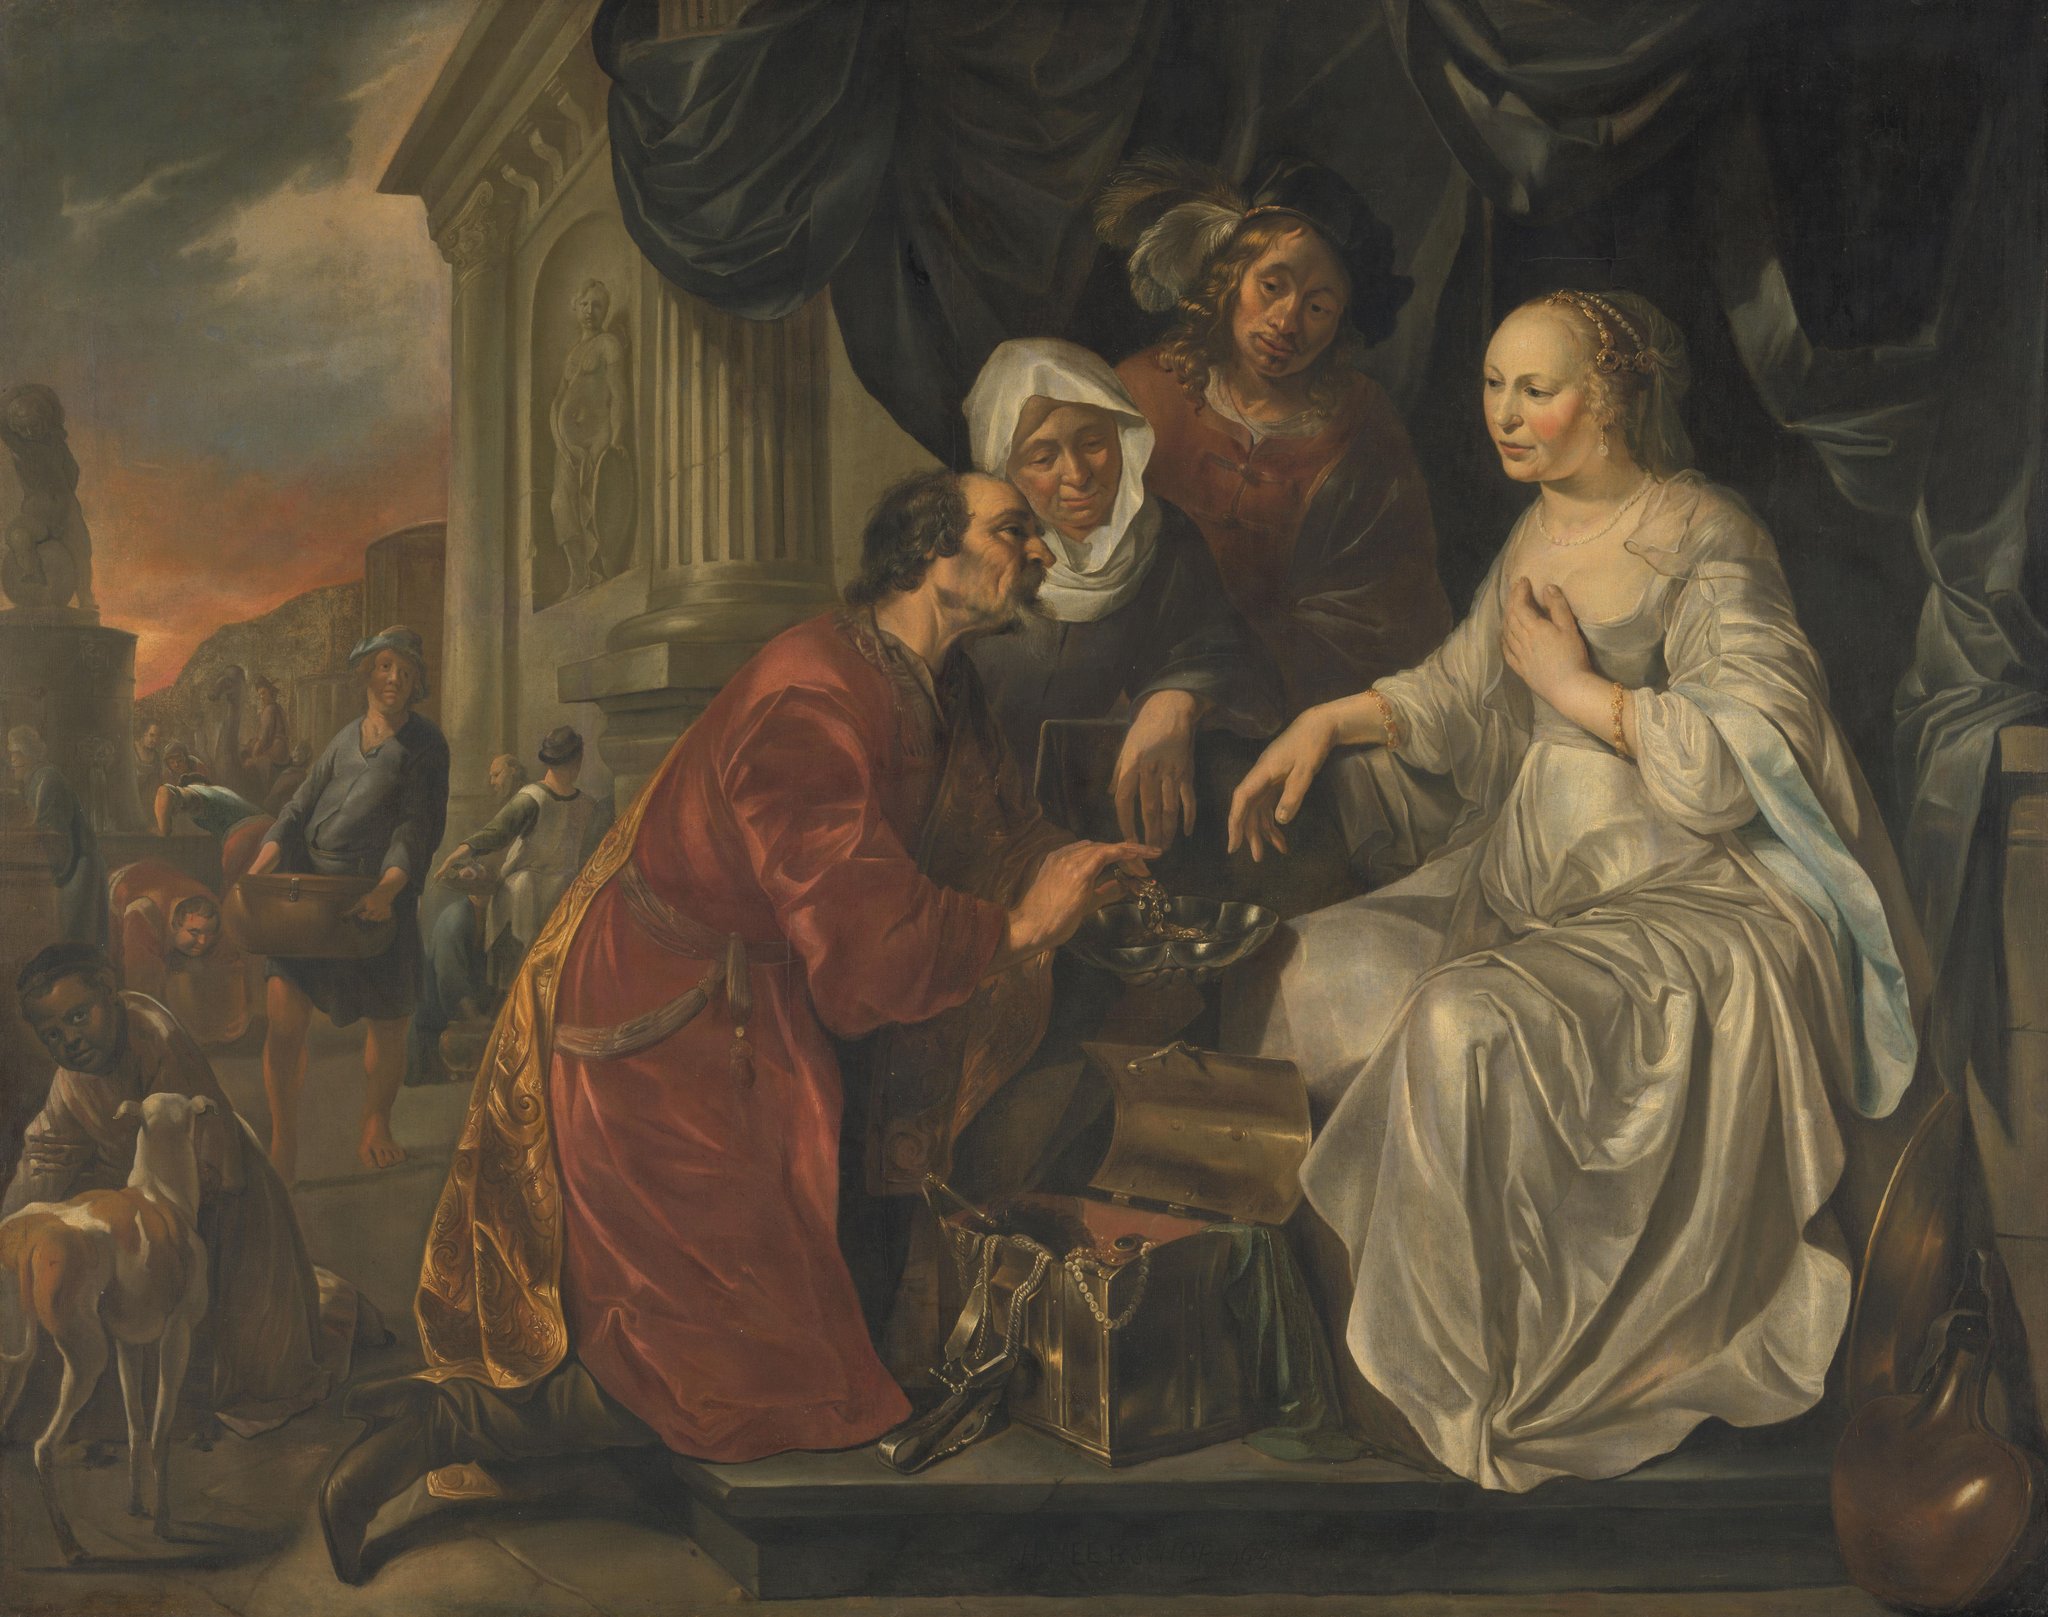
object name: painting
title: Rebecca Receiving Presents from Abraham's Servant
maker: hendrick heerschop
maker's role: painter, print maker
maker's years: 1626-1690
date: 1656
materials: canvas, oil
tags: gifts of clothing, gold and jewellery are offered to rebekah's parents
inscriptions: signature and date: ‘H. Heerschop 1656’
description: Rebecca ontvangt geschenken van Abrahams knecht. Rebecca zit rechts op een verhoging, onder een gordijn. De knecht knielt voor haar een toont sieraden. Op de grond staat een leren tas met meer sieraden en geschenken. Links een knielende zwarte jongen bij een hond.